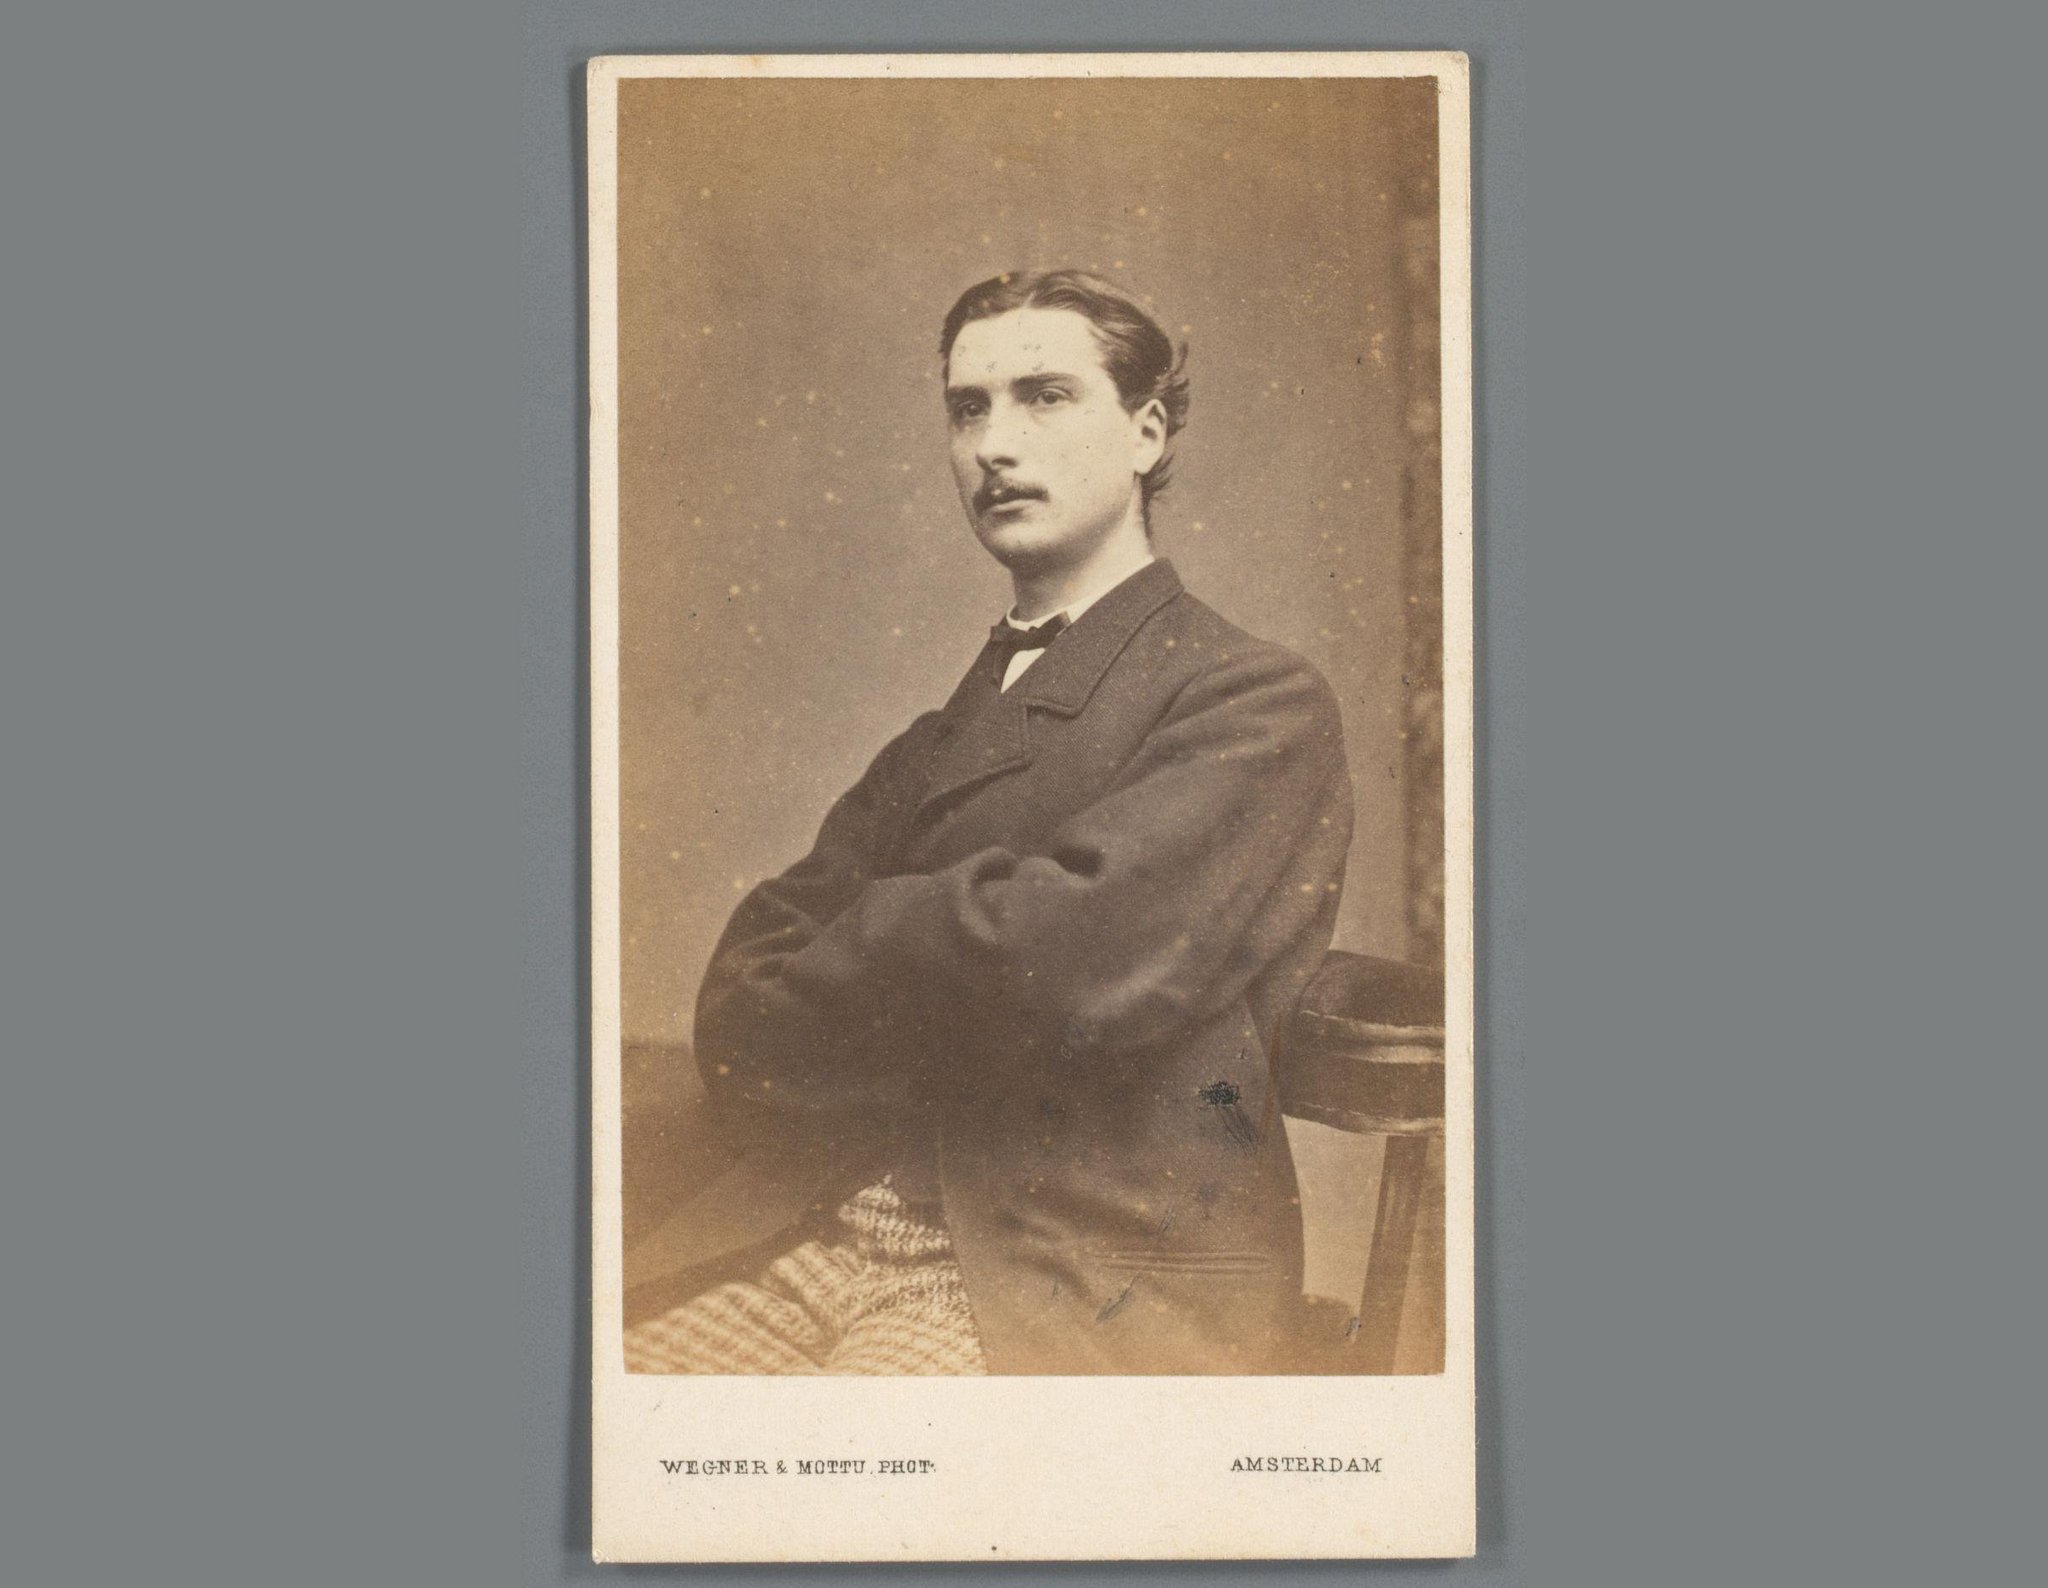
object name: photograph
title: Portret van een onbekende man uit de familie en de kring van Eugene van Delden en Belle van Delden-Denninghof Stelling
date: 1865-1875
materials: cardboard, paper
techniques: albumen print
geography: amsterdam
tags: historical persons not known by name - bb - woman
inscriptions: inscription: ‘Photogr. Atelier/ Wegner & Mottu,/ Kalverstraat/ Over den Heyligenweg D. 26/ Amsterdam’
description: Portret uit de kring van Eugene van Delden (Hartapoera, 1865 - Den Haag, 1954) en Belle van Delden-Denninghof Stelling (Batavia, 1870 - Den Haag, 1947).